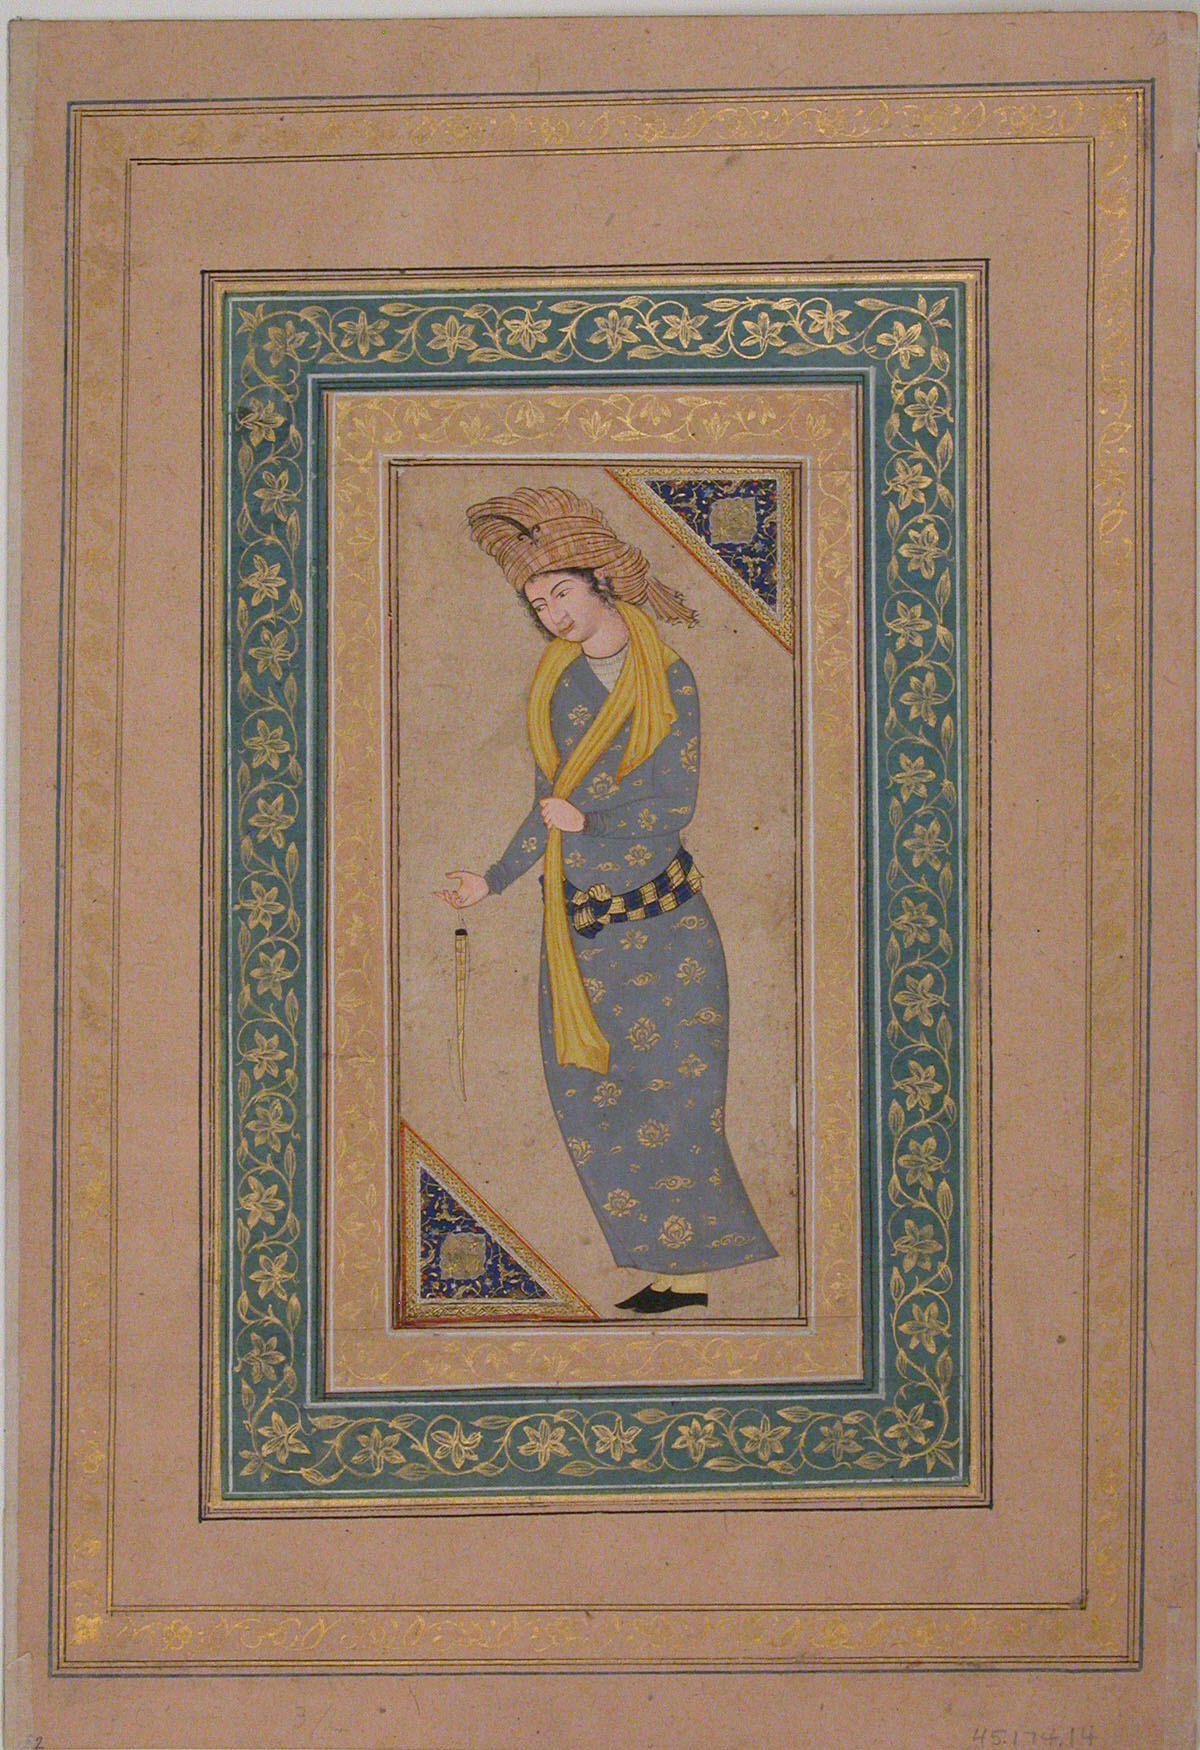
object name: album leaf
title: Portrait of a Man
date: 1601-1633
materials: gold, ink, paper, watercolor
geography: iran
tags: men,portraits